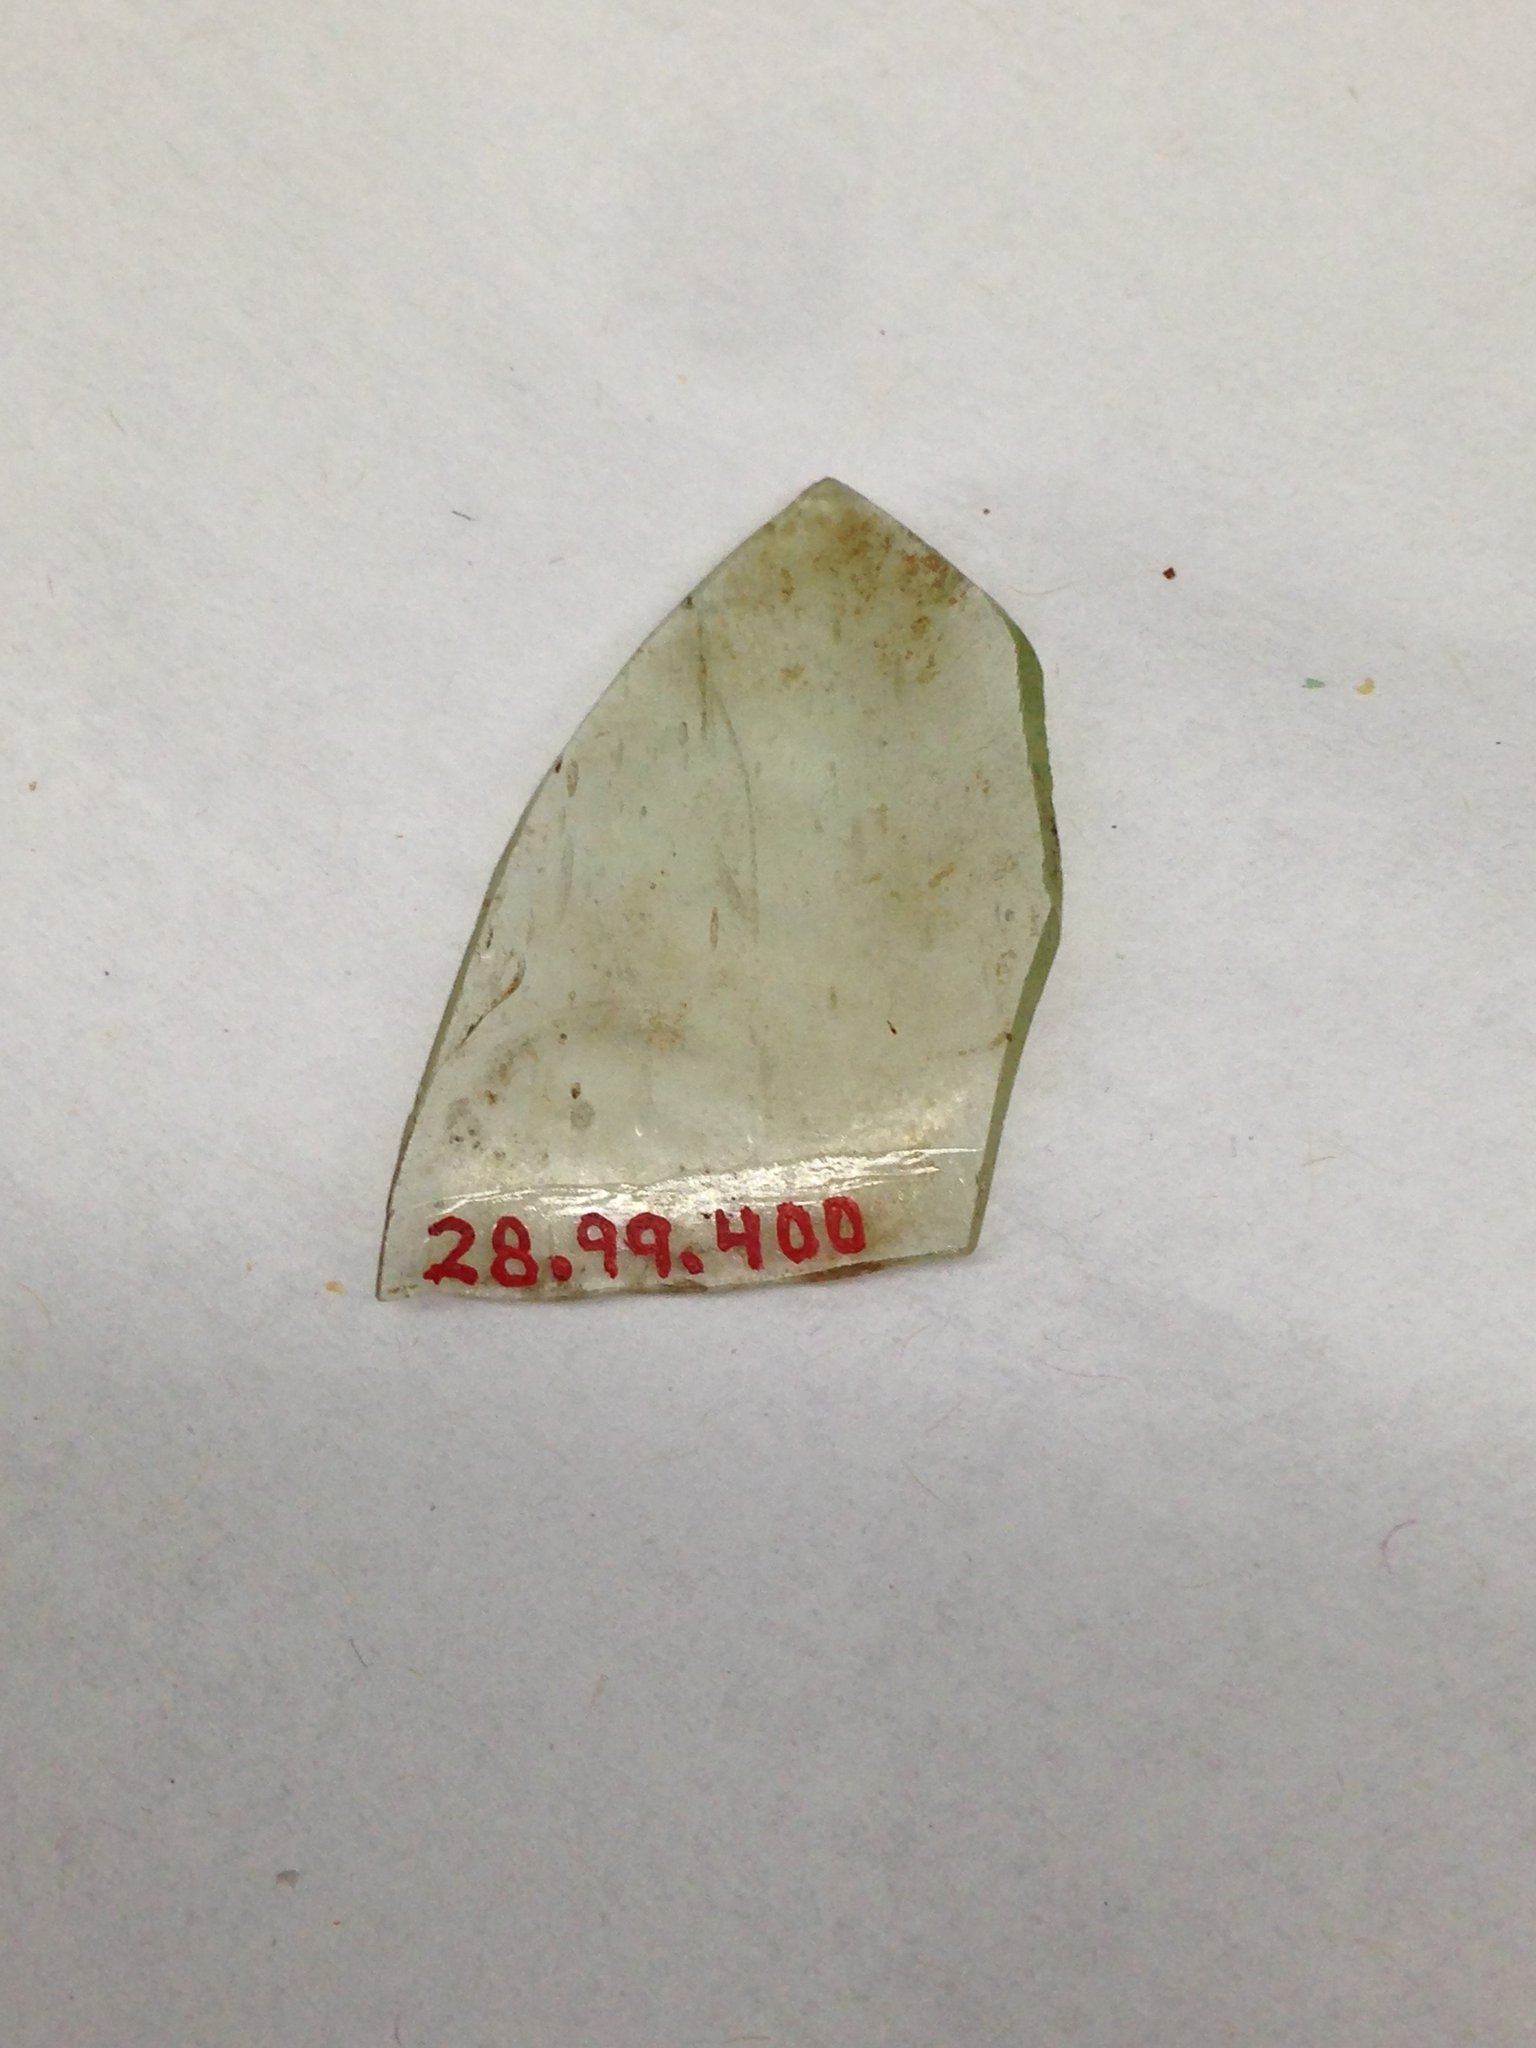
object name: fragment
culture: european or middle eastern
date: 1150-1250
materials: ceramic, glass